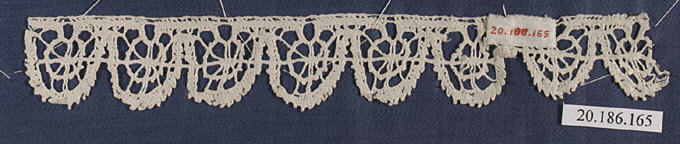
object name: edging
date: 1601-1700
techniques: lace